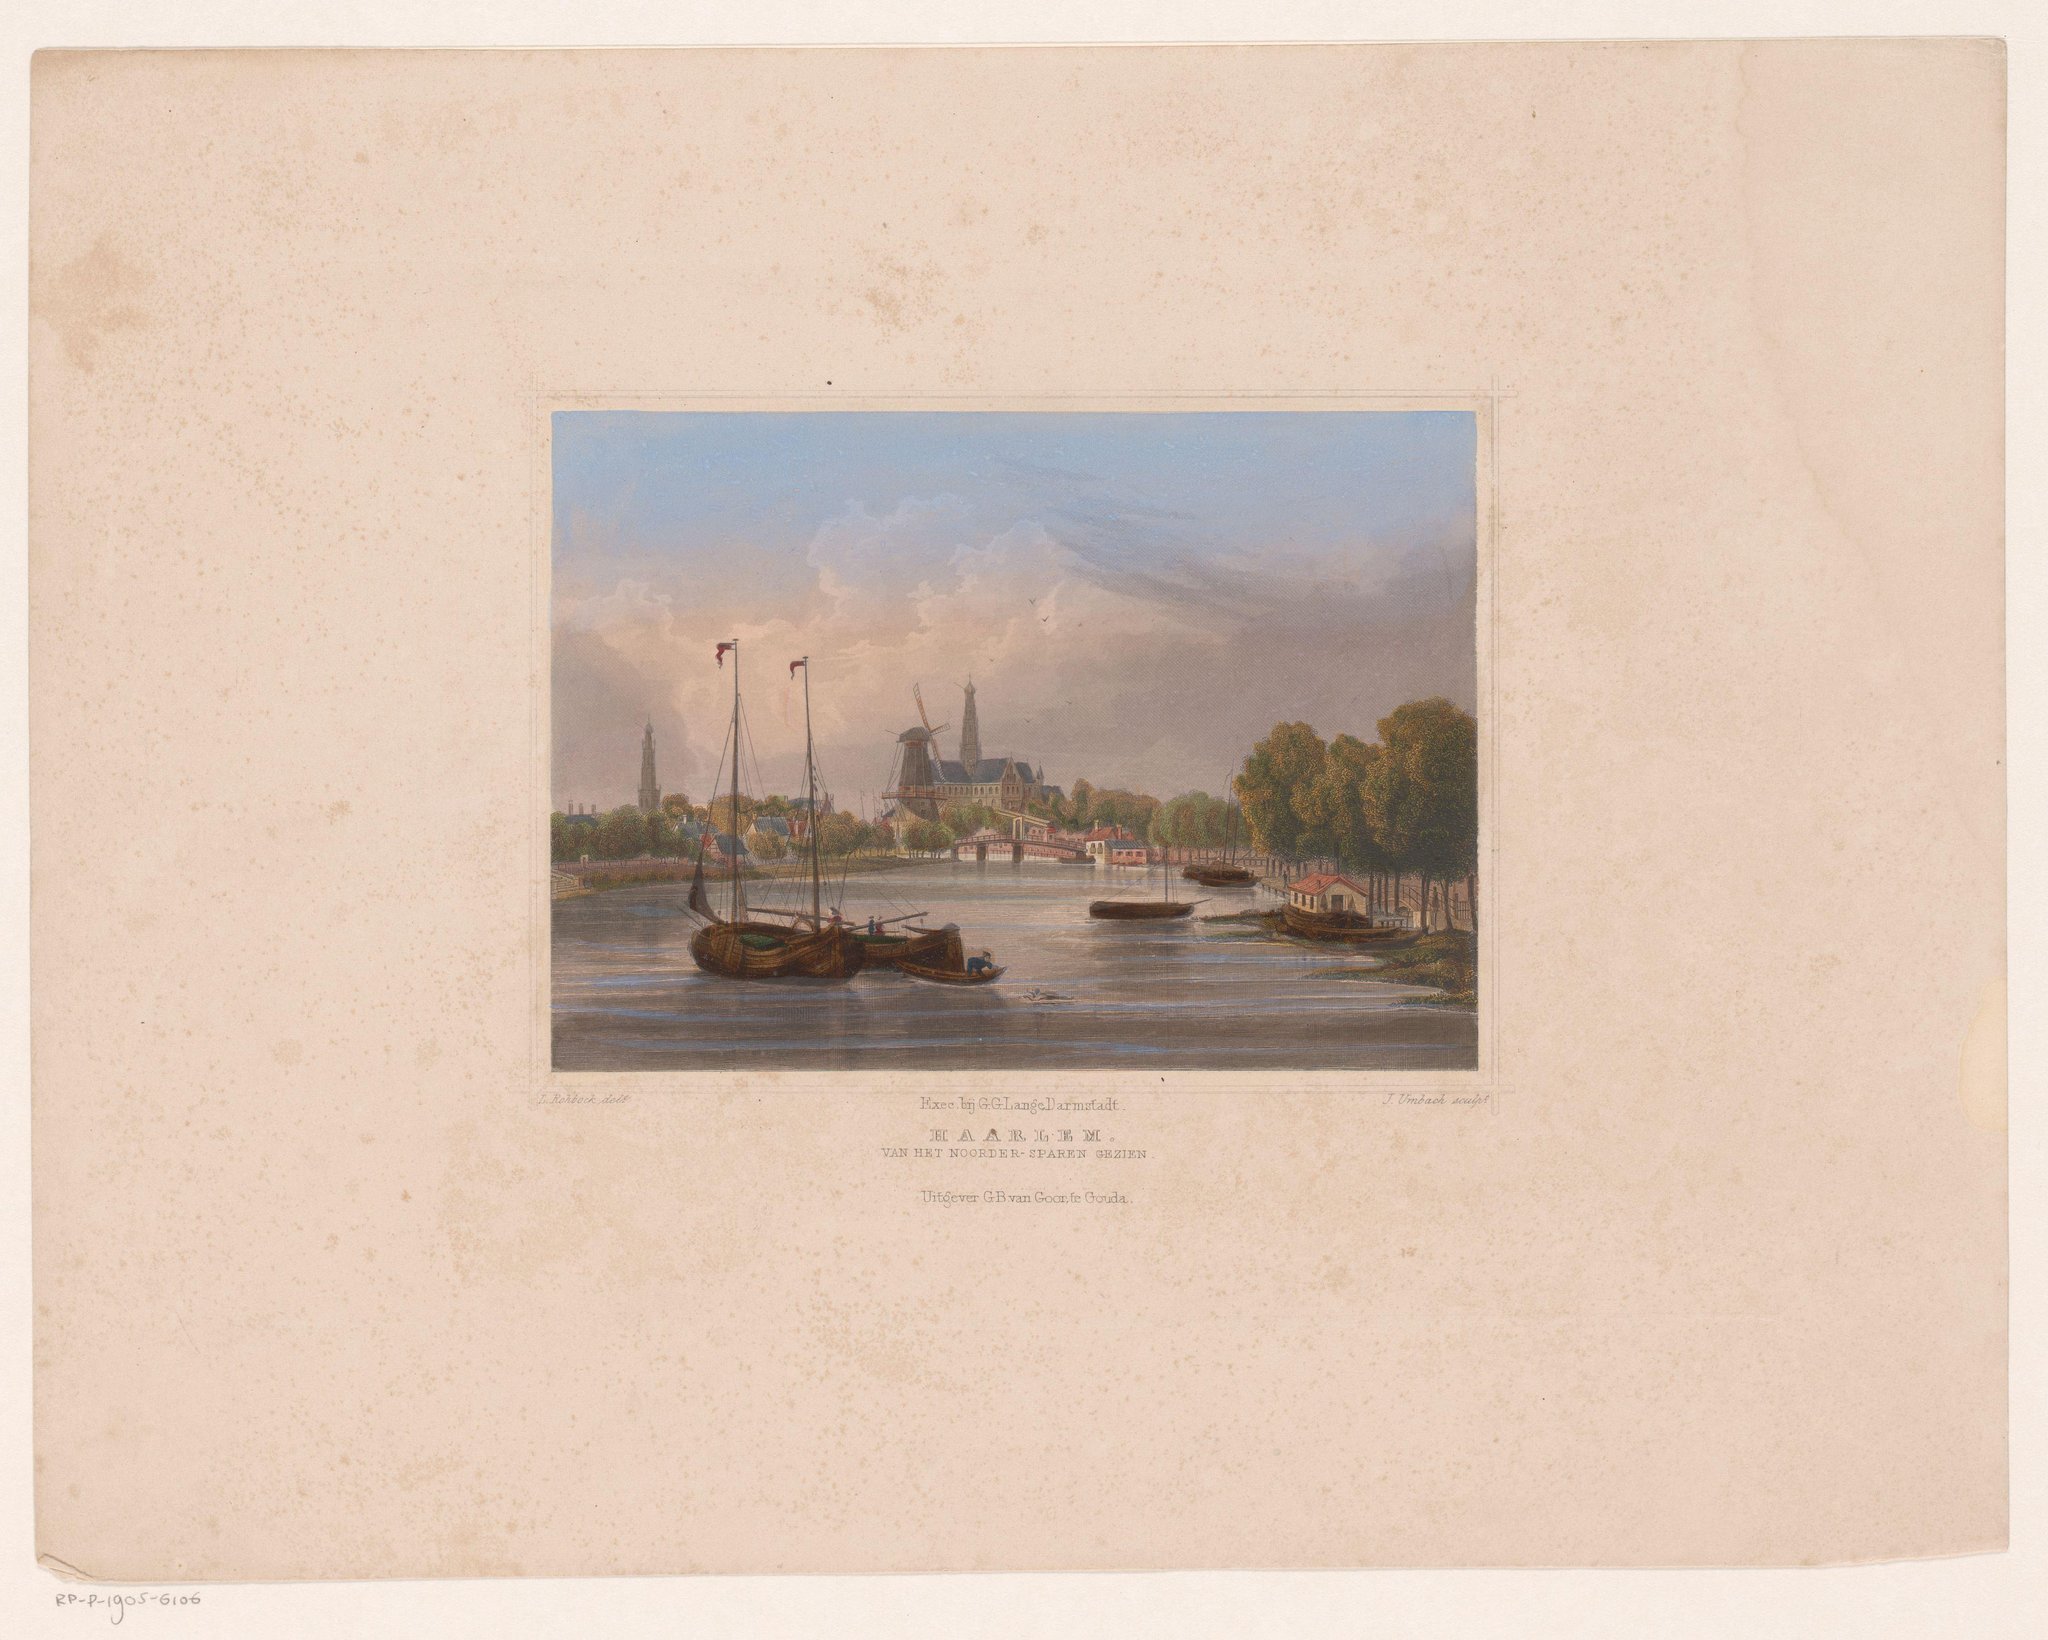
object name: print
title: Haarlem van het Noorder-Sparen gezien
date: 1858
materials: paper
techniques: hand coloring, engraving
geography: gouda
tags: city-view in general; 'veduta', church (exterior), windmill, haarlem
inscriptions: collector's mark: Lugt 2228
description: Prent gebruikt voor de publicatie: Terwen, Johannes Leonardus. Het Koningrijk der Nederlanden: voorgesteld in eene reeks van naar de natuur geteekende schilderachtige gezigten en beschreven. Gouda: Gerrit Benjamin van Goor, 1858.